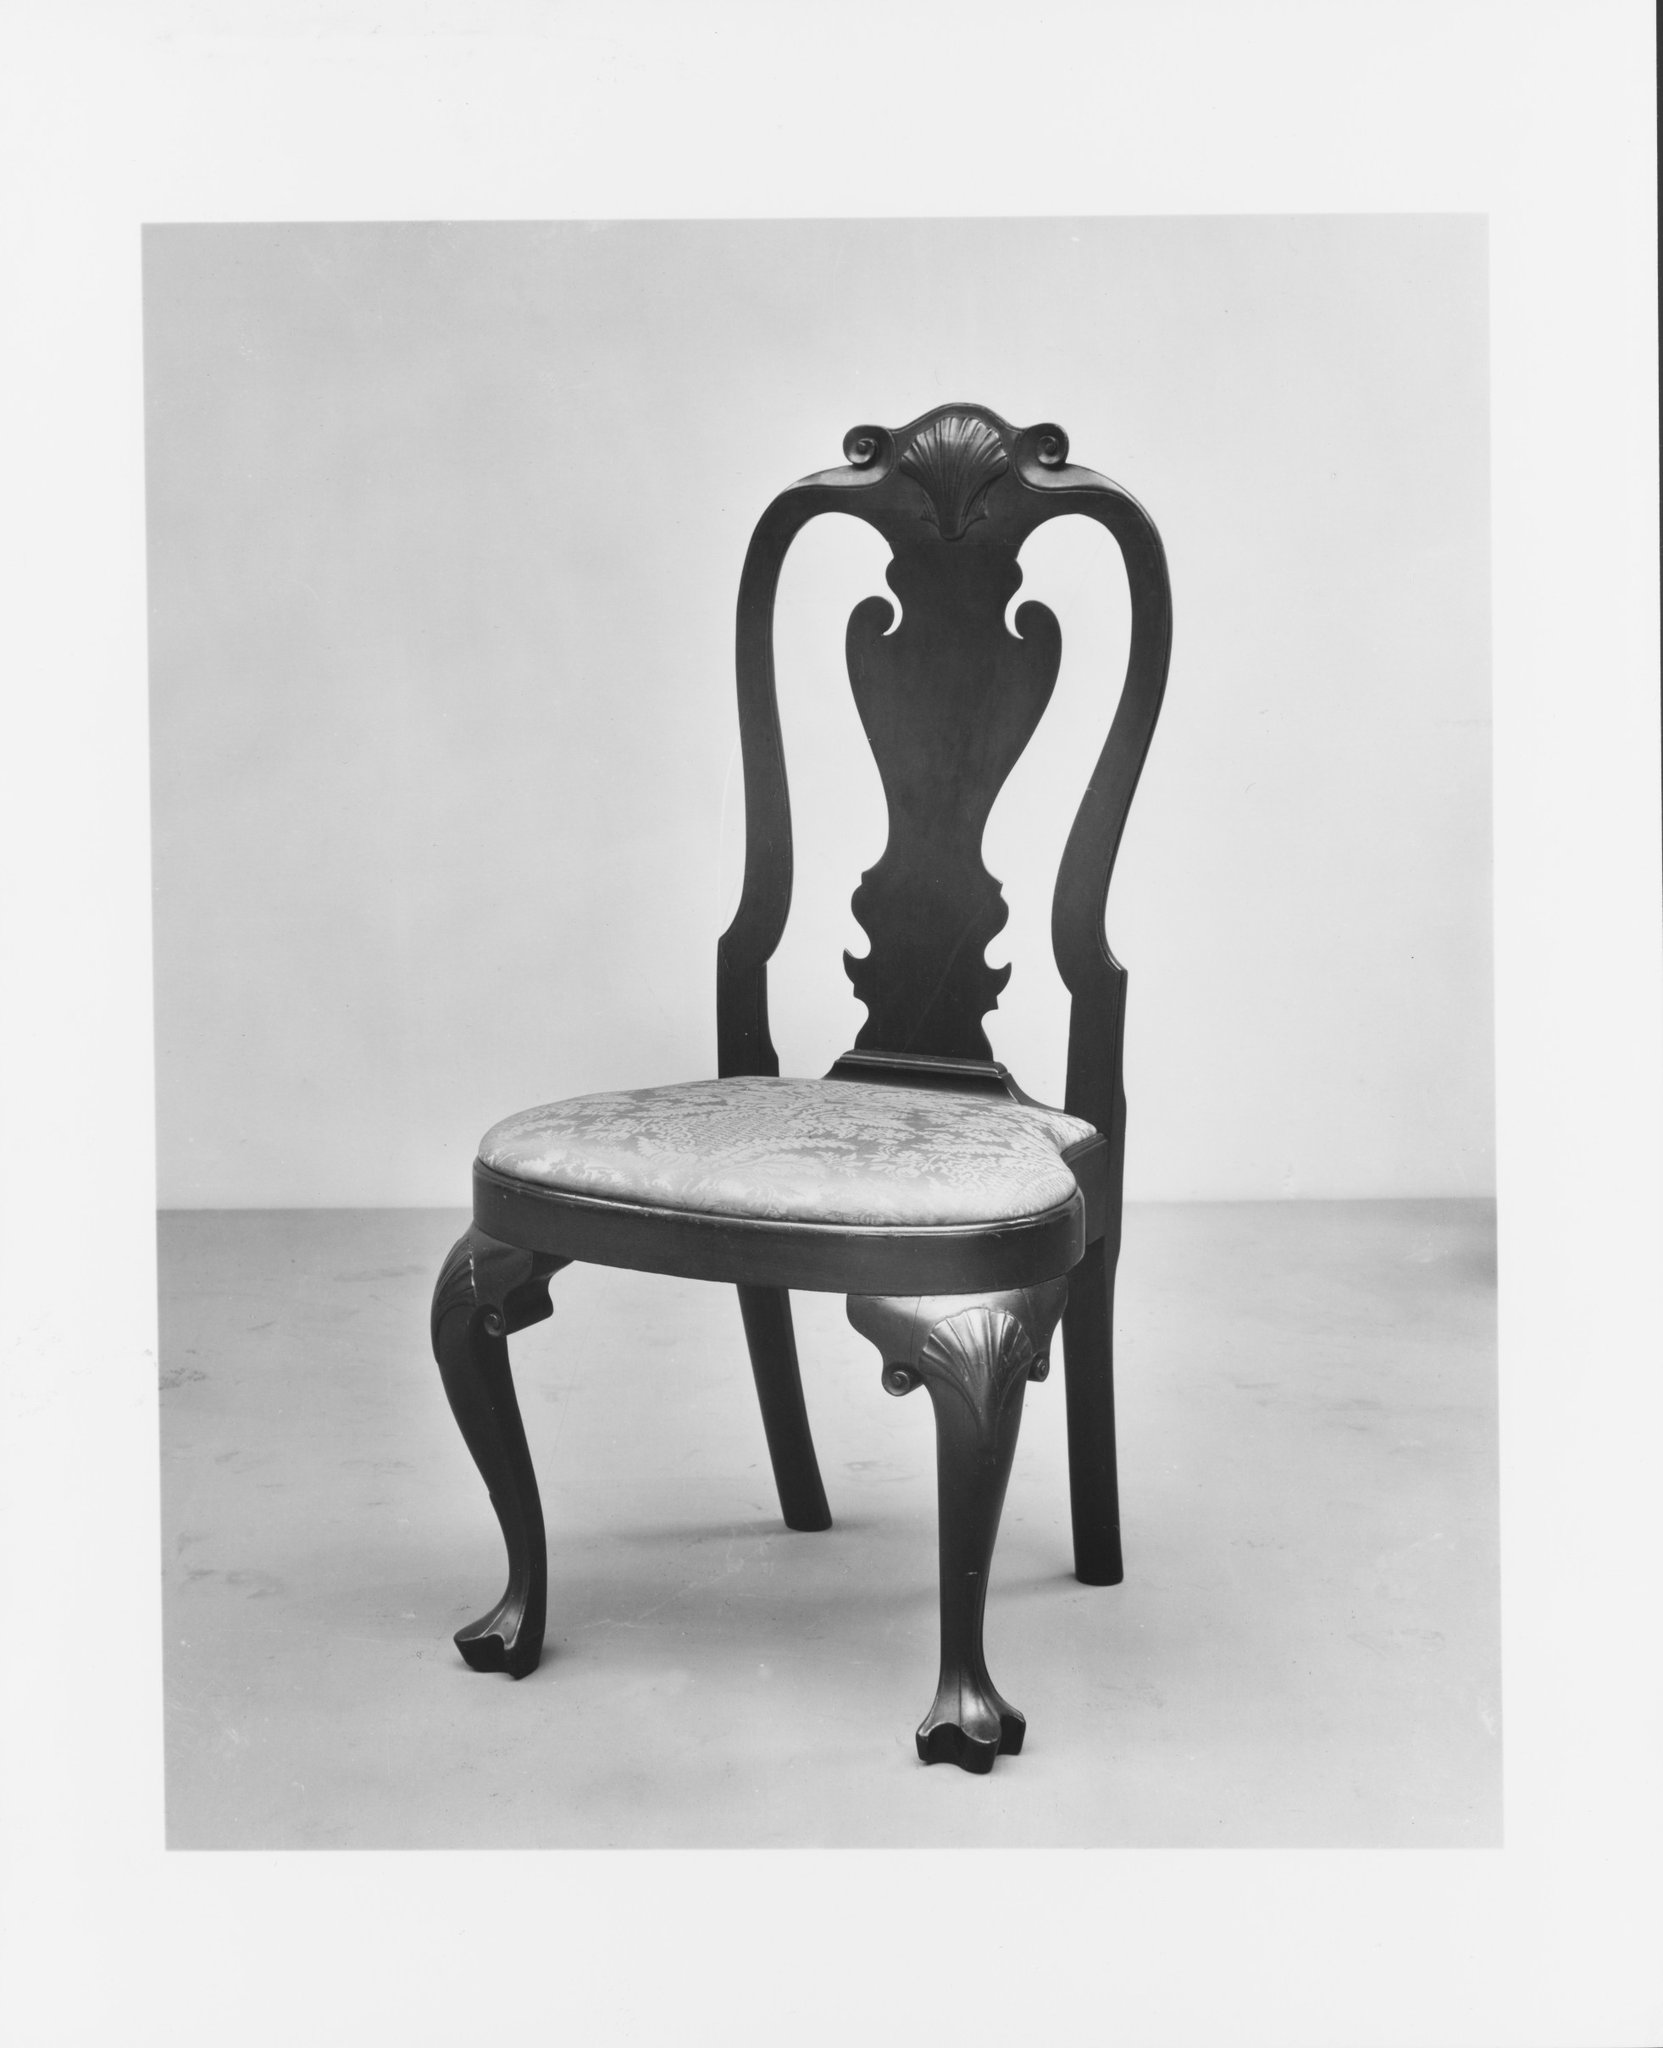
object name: side chair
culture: american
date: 1740-1760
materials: wood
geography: united states